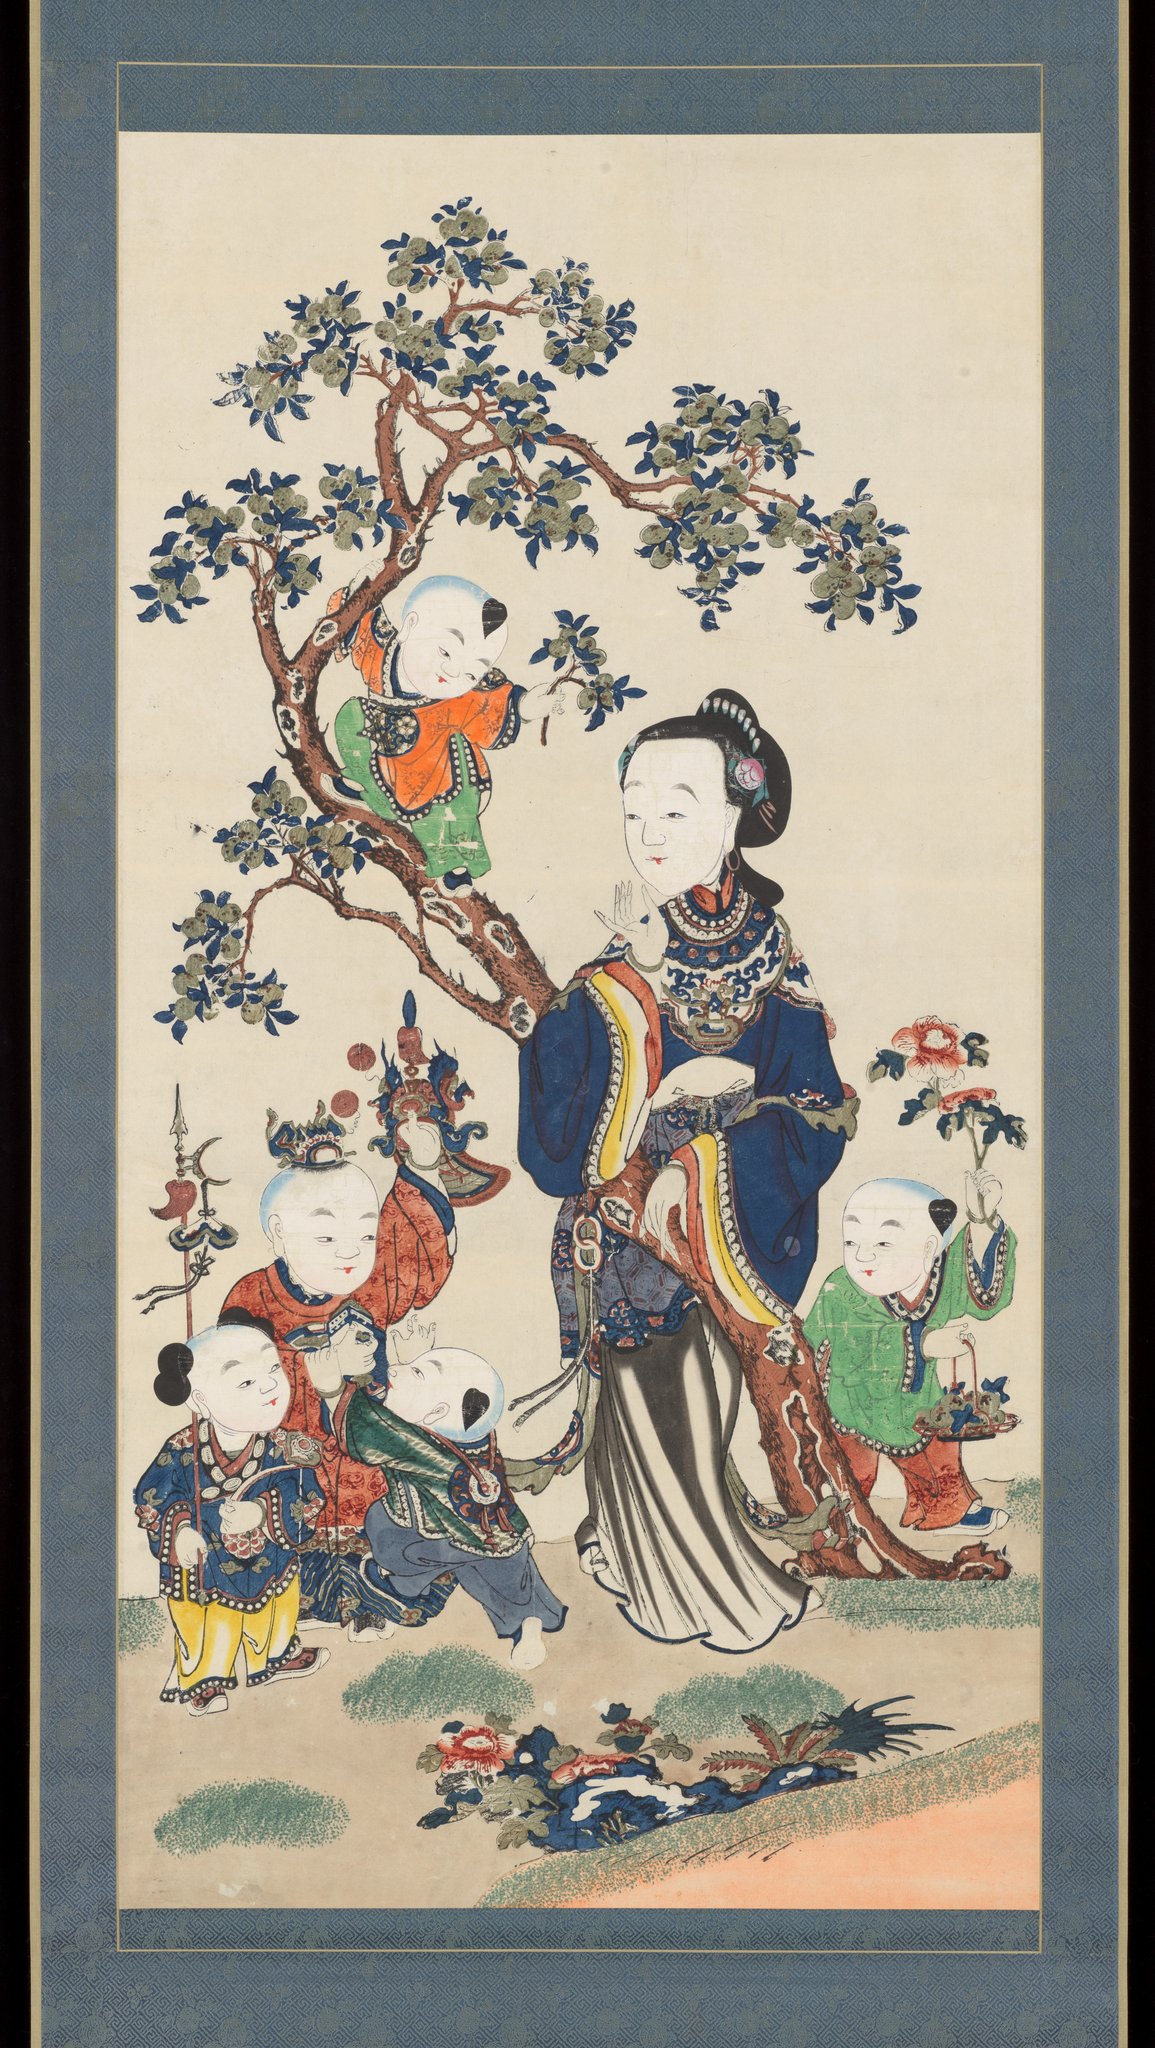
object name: print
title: May You Soon Bear Noble Sons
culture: chinese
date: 1736-1795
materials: ink, paper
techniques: hand coloring, woodblock print